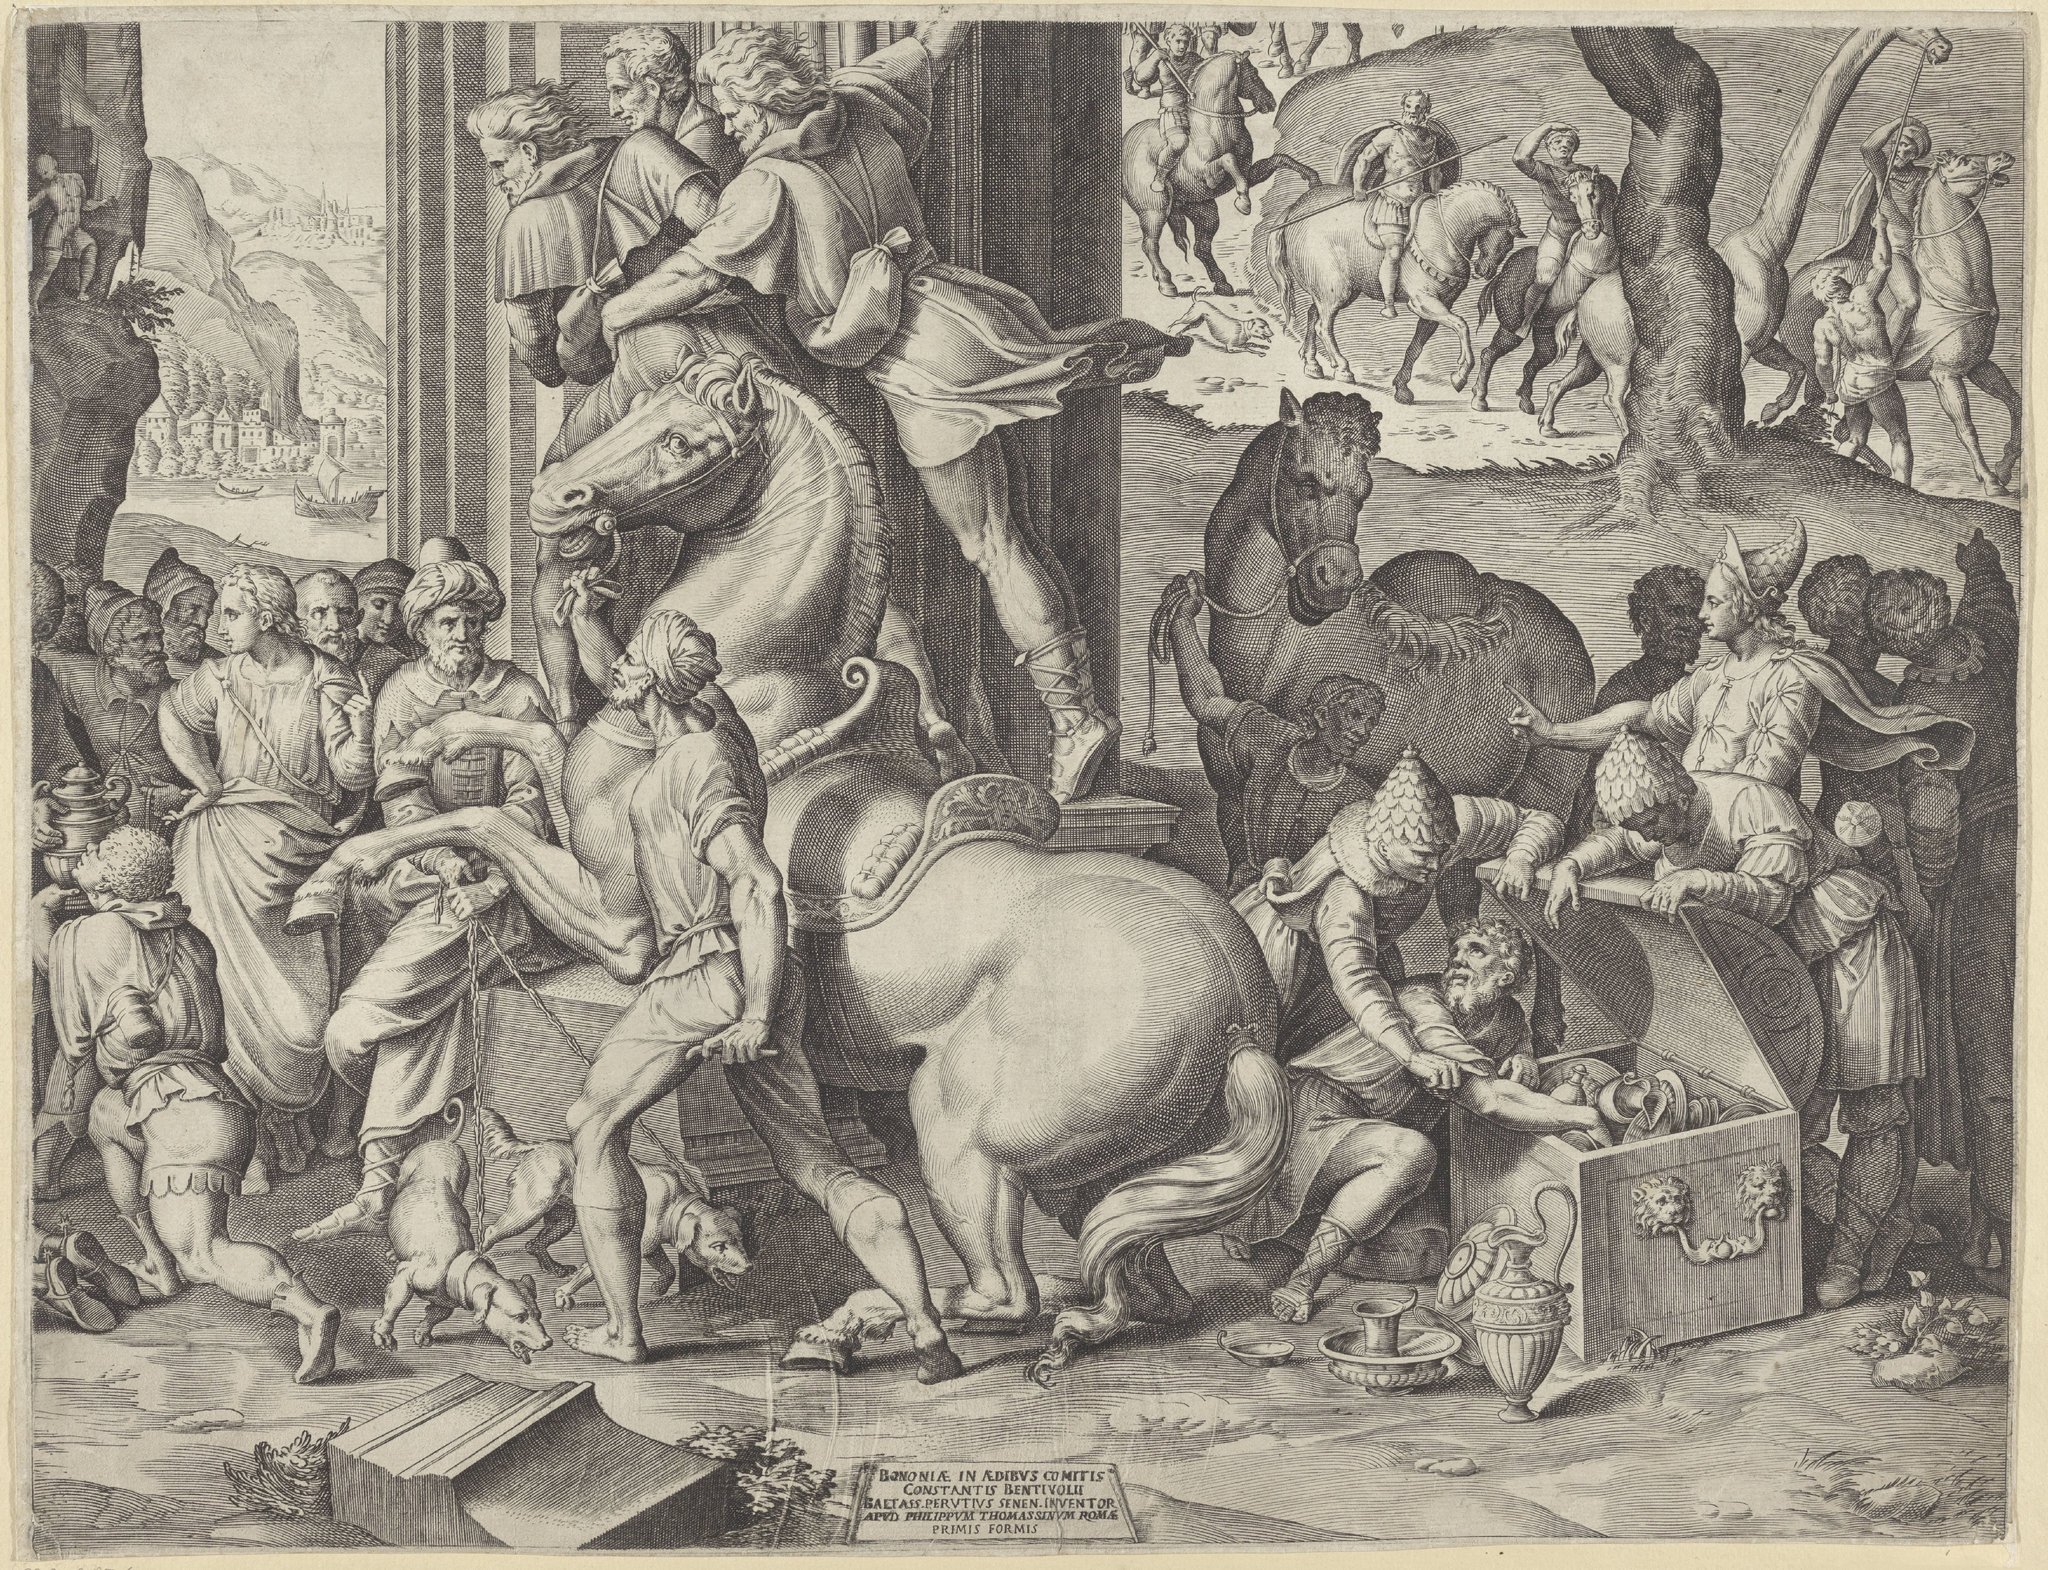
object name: print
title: Aanbidding door de koningen (deel rechtsonder)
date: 1567-1602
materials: paper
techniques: engraving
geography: bologna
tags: adoration of the kings: the wise men present their gifts to the christ-child (gold, frankincense and myrrh)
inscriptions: collector's mark: Lugt 240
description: Deze prent is onderdeel van een grote prent gedrukt van zeven platen op zeven bladen die aan elkaar gemonteerd moesten worden. In de collectie van het Rijksmuseum bevinden zich vier van de zeven delen. Naar een tekening door Peruzzi in het British Museum te Londen.